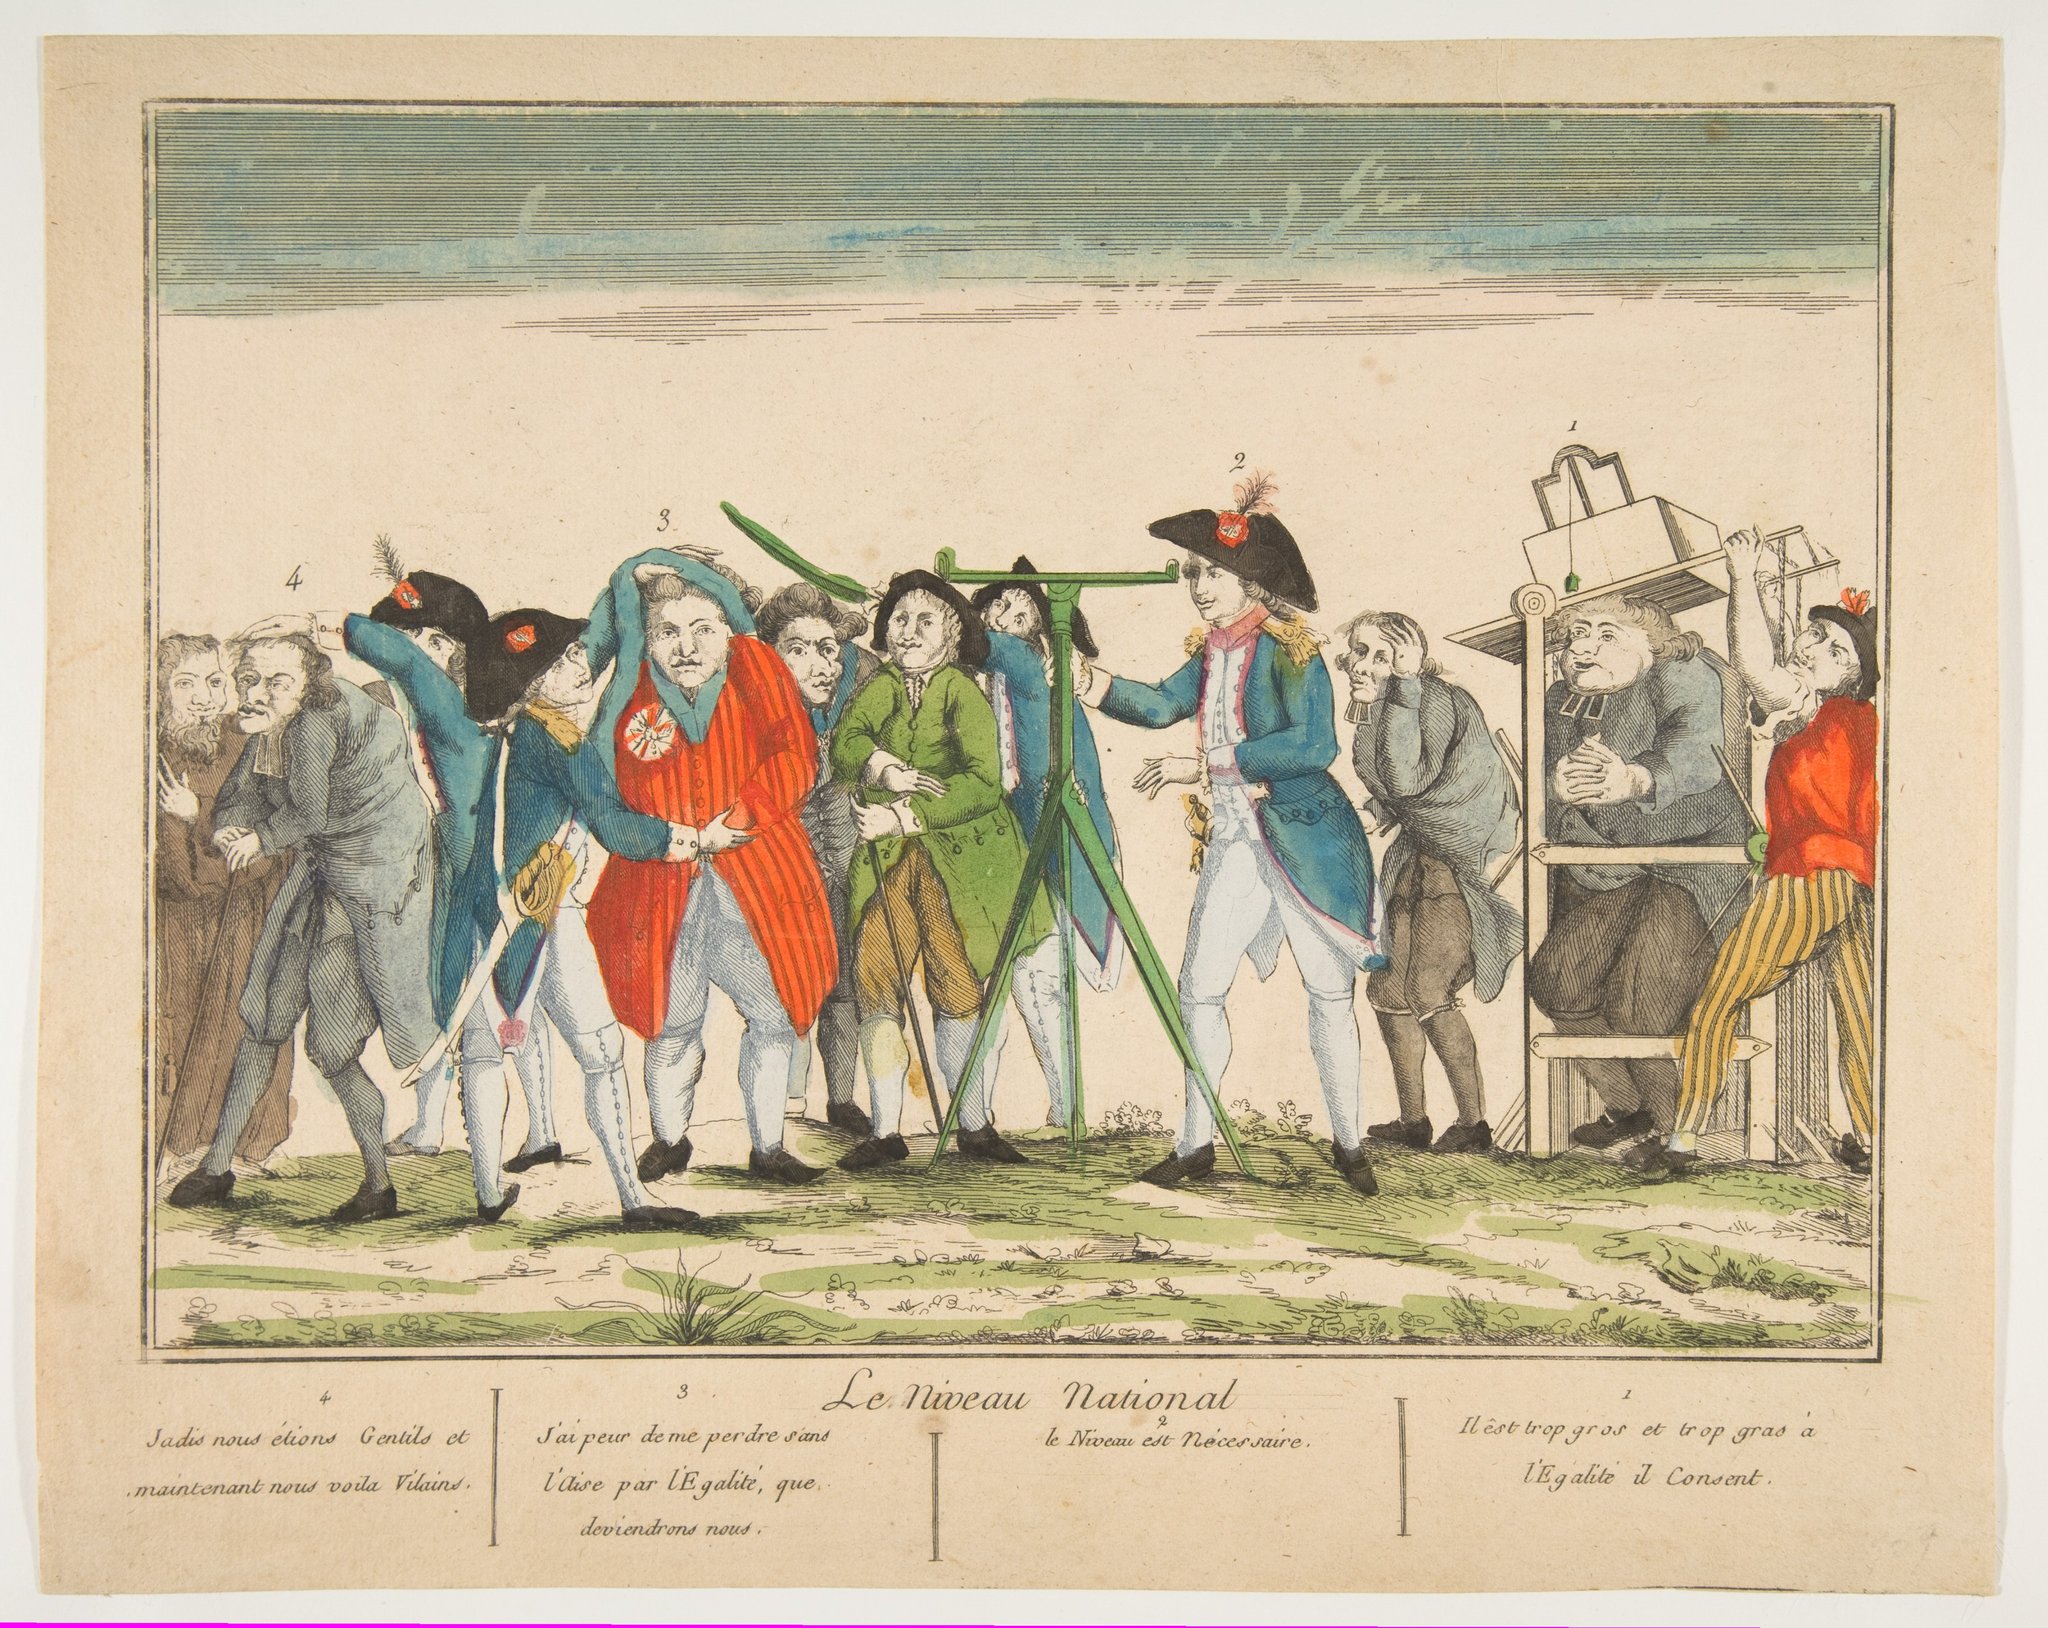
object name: print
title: Le Niveau Nationale (The National Level)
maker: anonymous, french, 18th century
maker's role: artist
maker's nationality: french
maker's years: 1700-1800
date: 1789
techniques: etching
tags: satire,french revolution,men